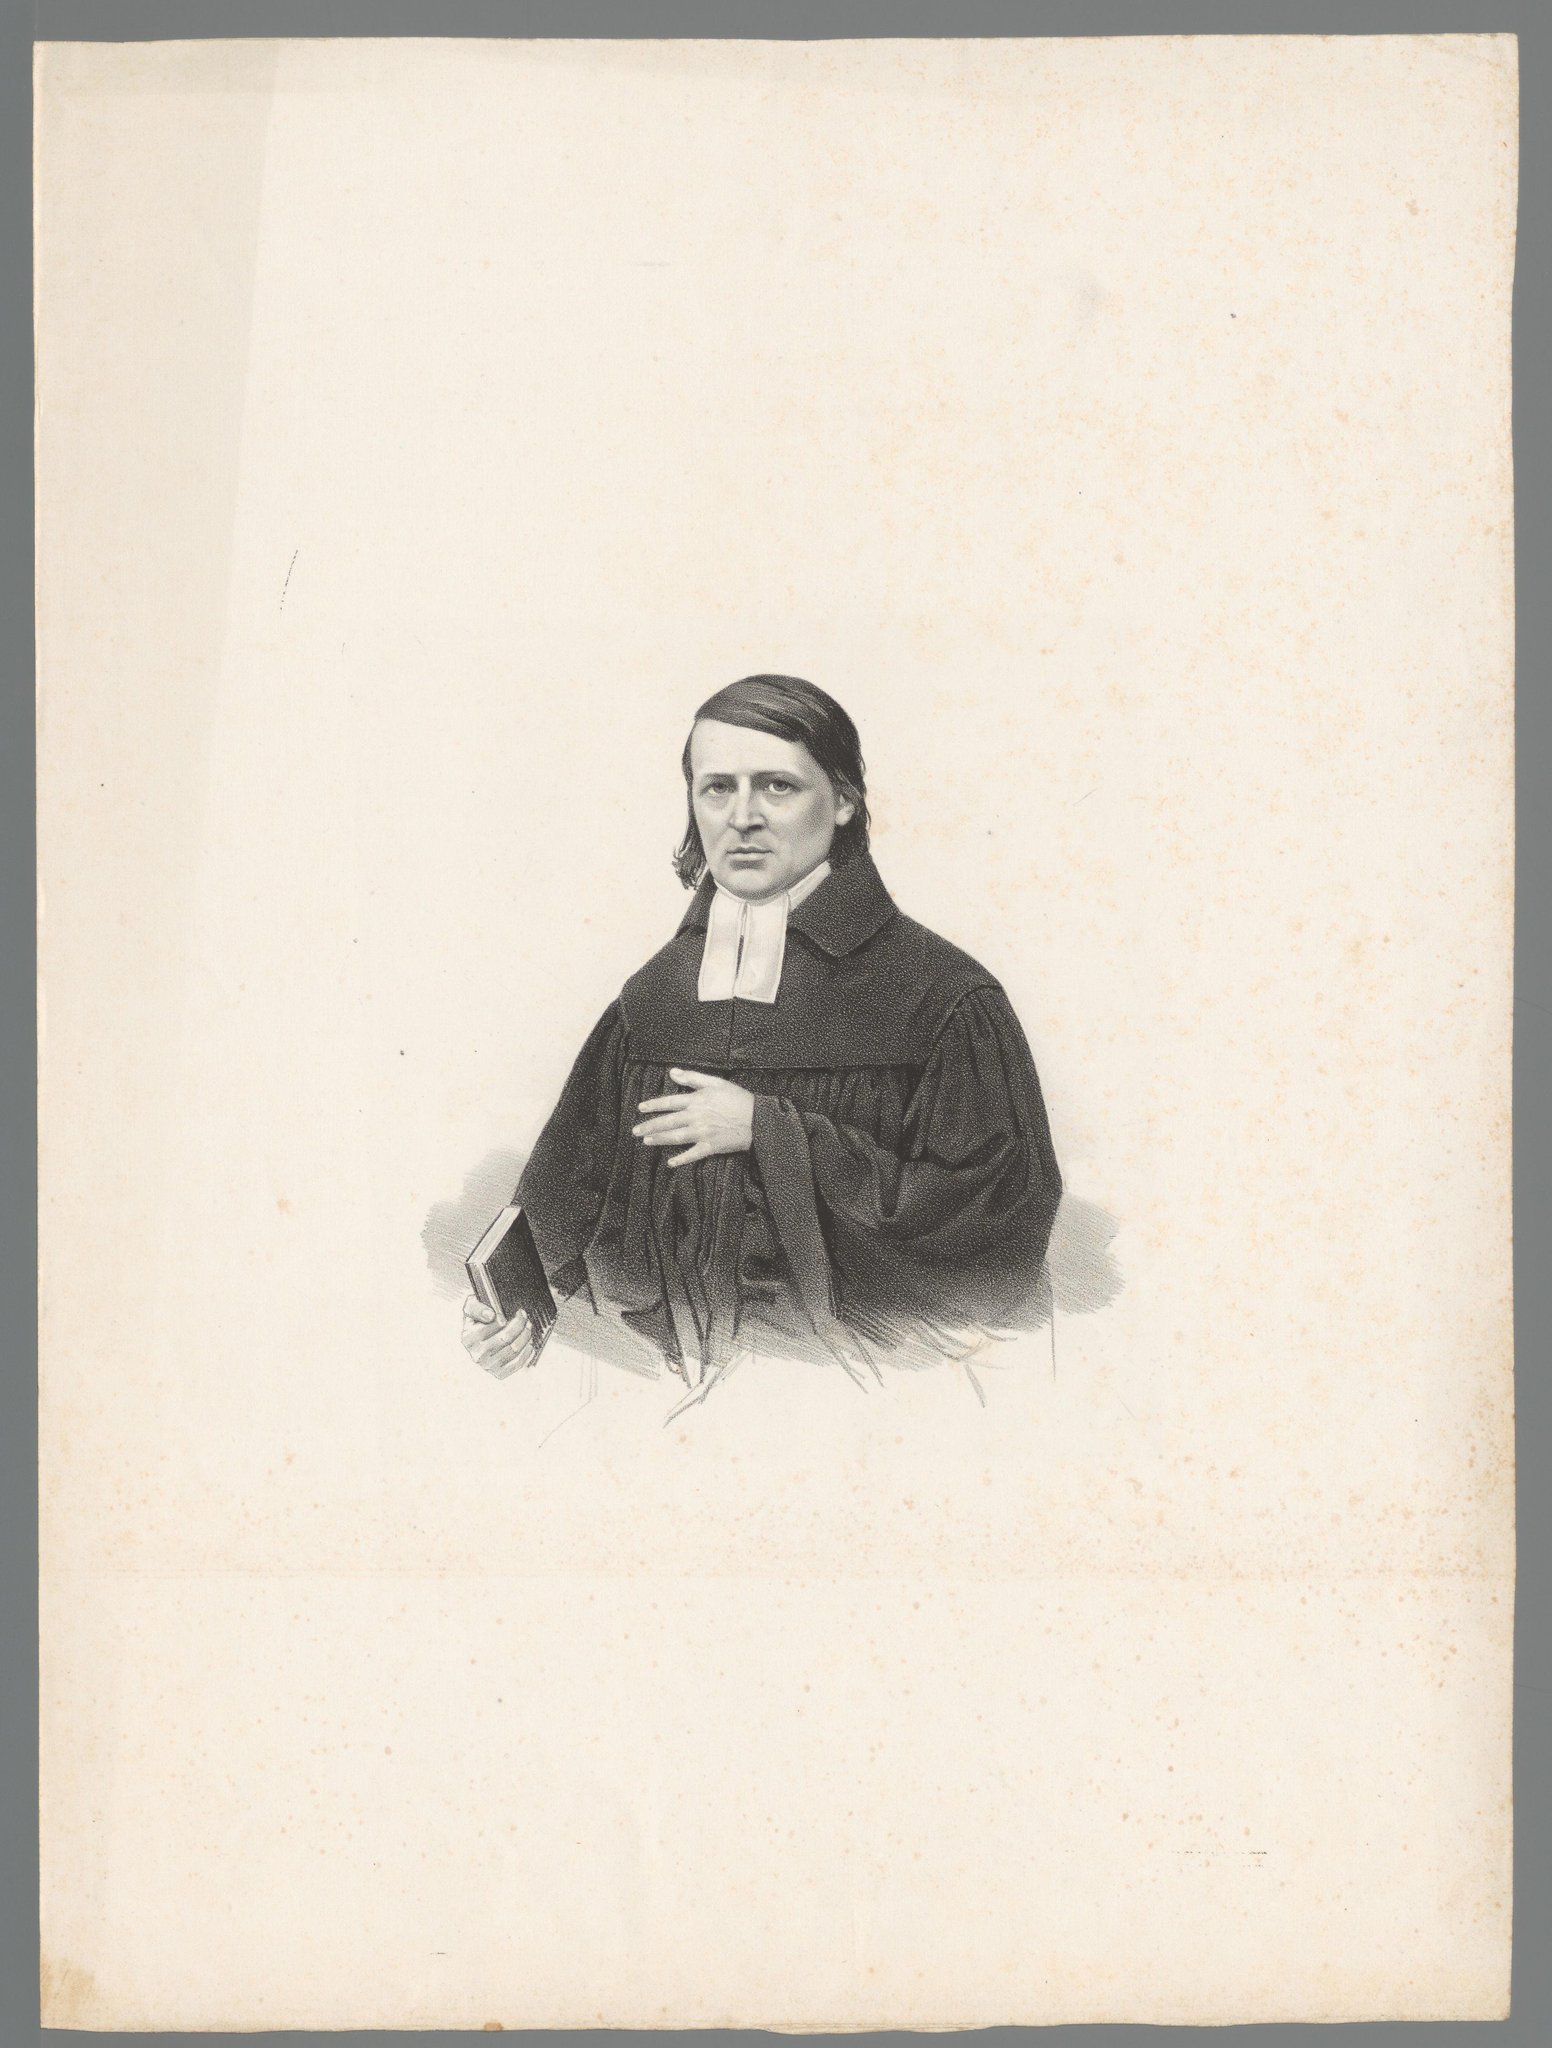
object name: print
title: Portret van Karl Theodor Albert Liebner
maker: friedrich eduard ritmüller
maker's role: printer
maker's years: 1805-1869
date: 1815-1868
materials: paper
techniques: lithograph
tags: theologian, historical persons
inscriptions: collector's mark: Lugt 2228